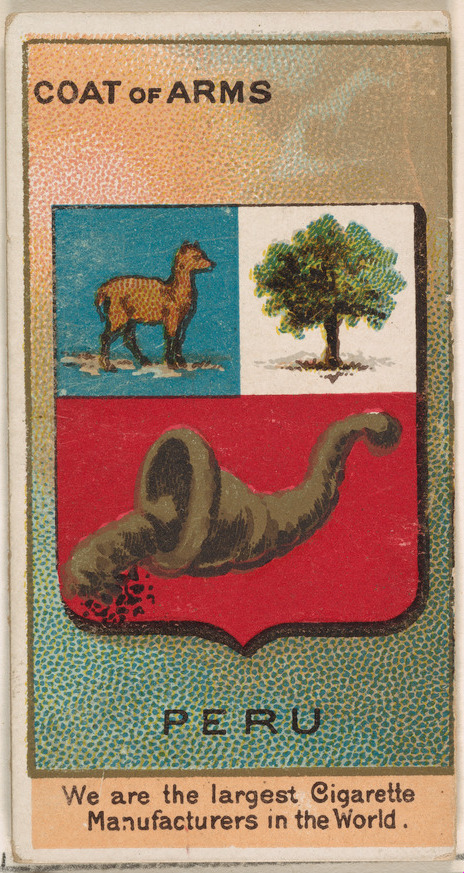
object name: print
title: General Caceres, President of Peru, from the Rulers, Flags, and Coats of Arms series (N126-2) issued by W. Duke, Sons & Co.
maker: w. duke, sons & co.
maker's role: publisher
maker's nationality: american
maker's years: 1870-1920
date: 1888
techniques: color lithograph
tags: animals,portraits,coat of arms,flags,generals